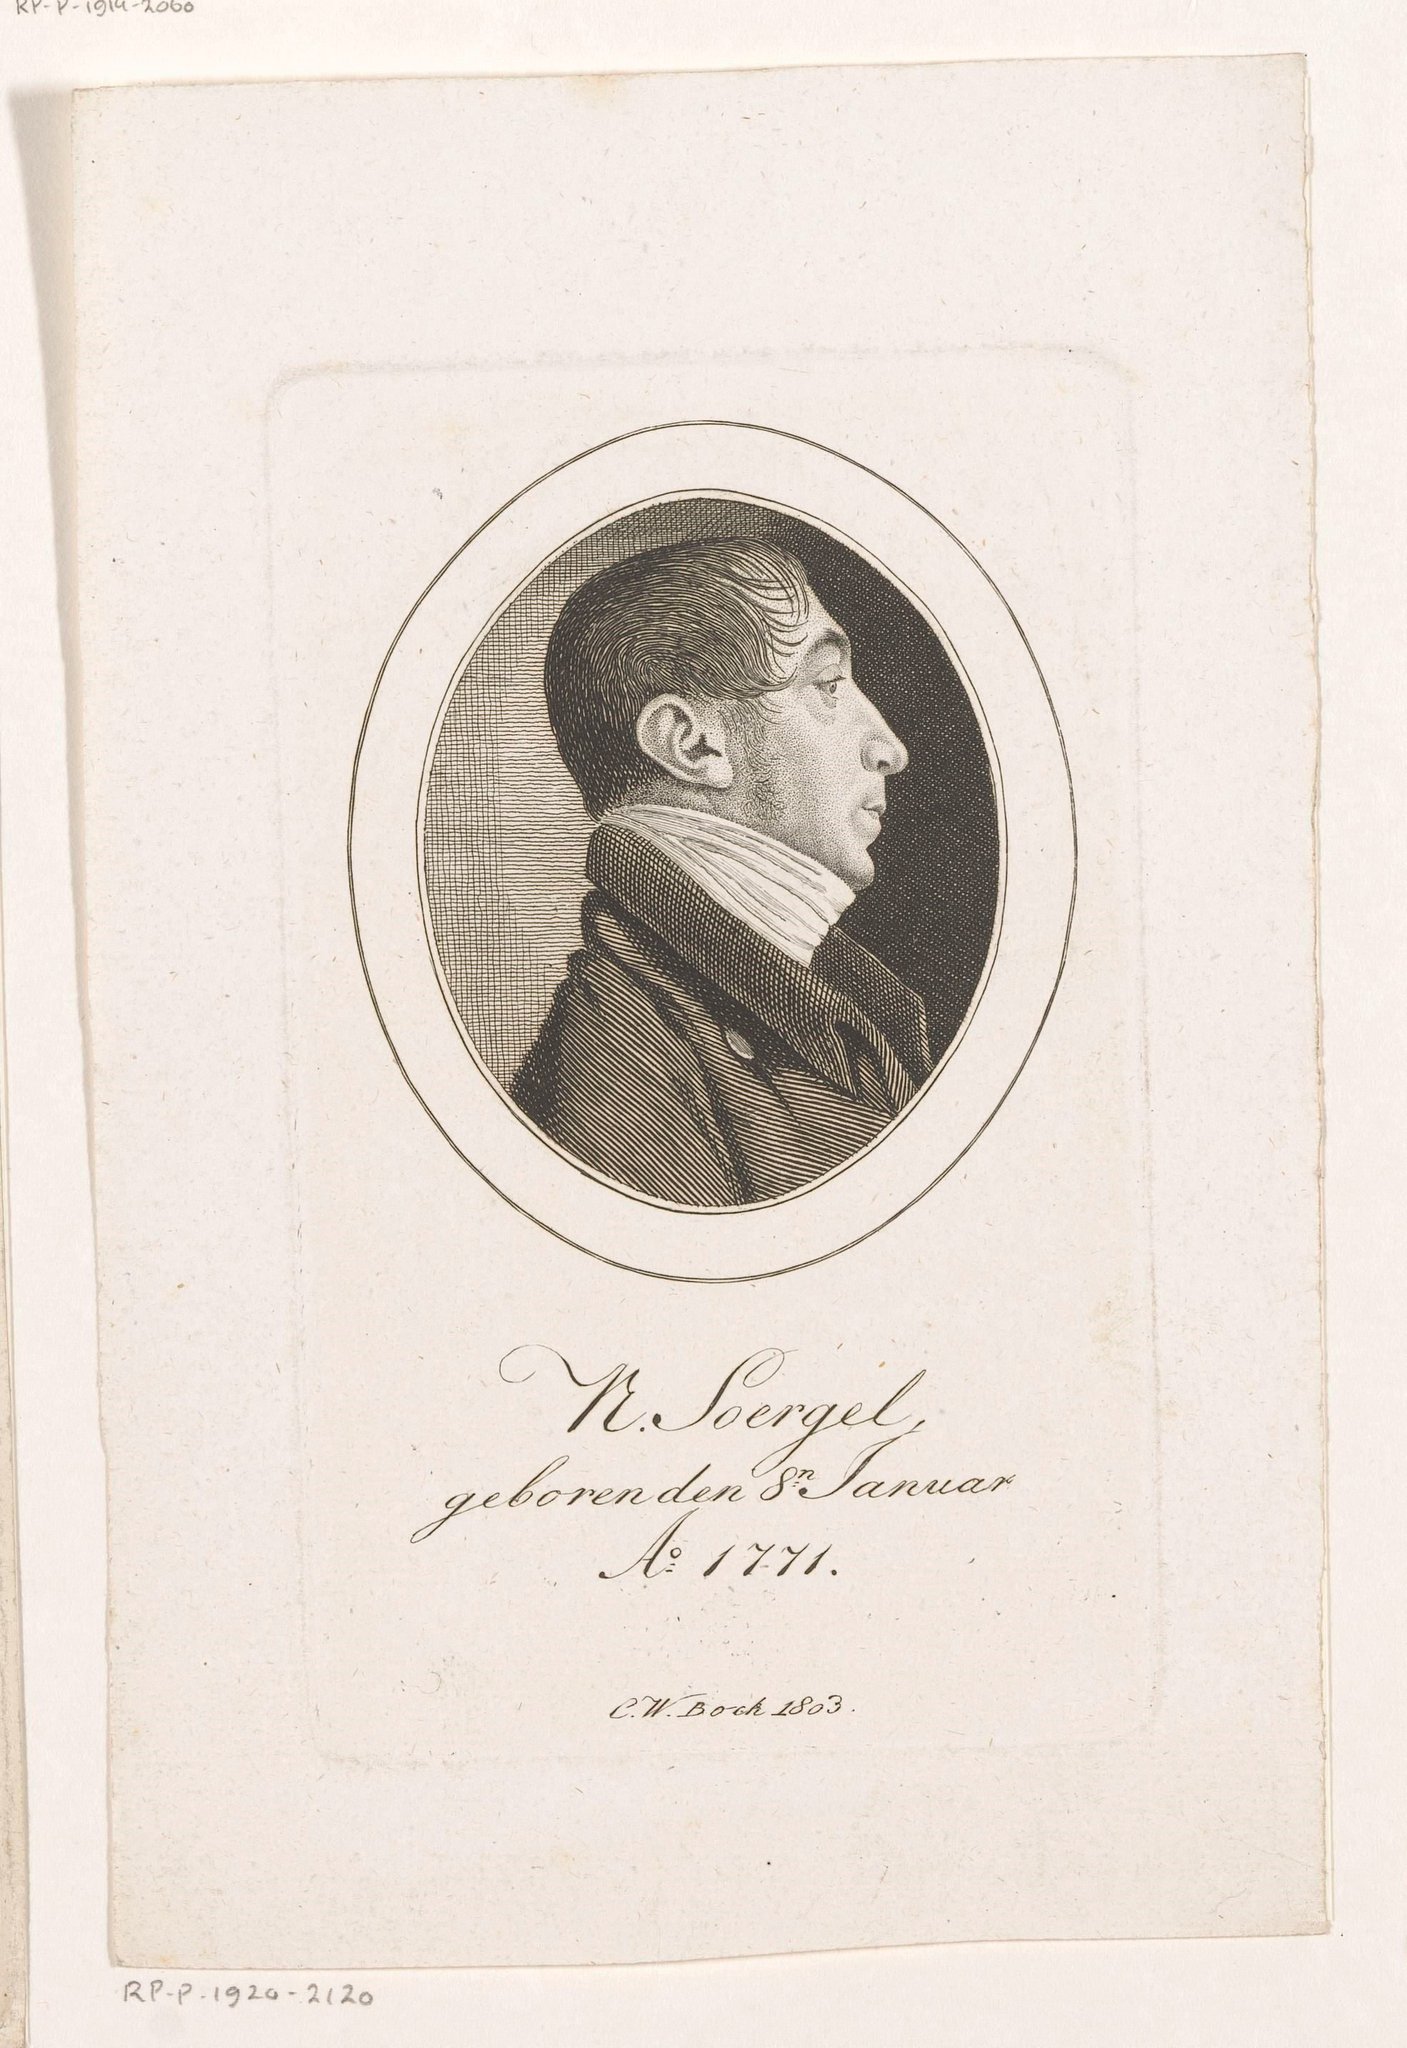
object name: print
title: Portret van Nicolaus Sörgel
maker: christoph wilhelm bock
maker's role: print maker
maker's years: 1755-1836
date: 1803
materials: paper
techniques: engraving, etching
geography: nuremberg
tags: historical persons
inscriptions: collector's mark: Lugt 2228